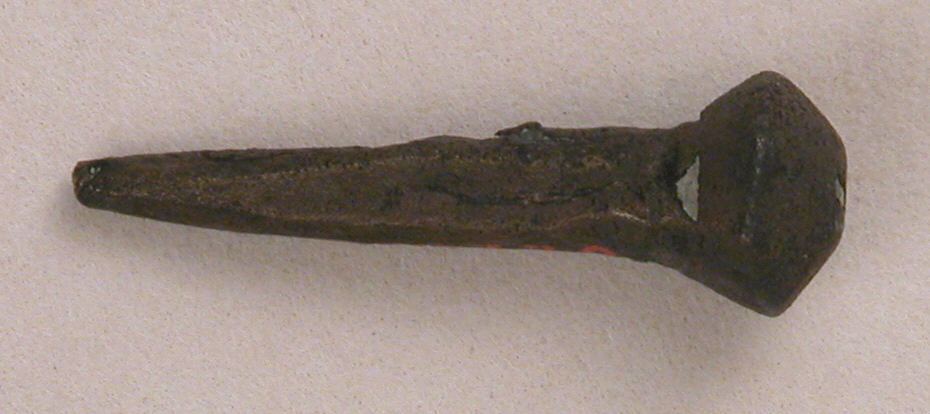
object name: nail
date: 401-800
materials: bronze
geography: palestine